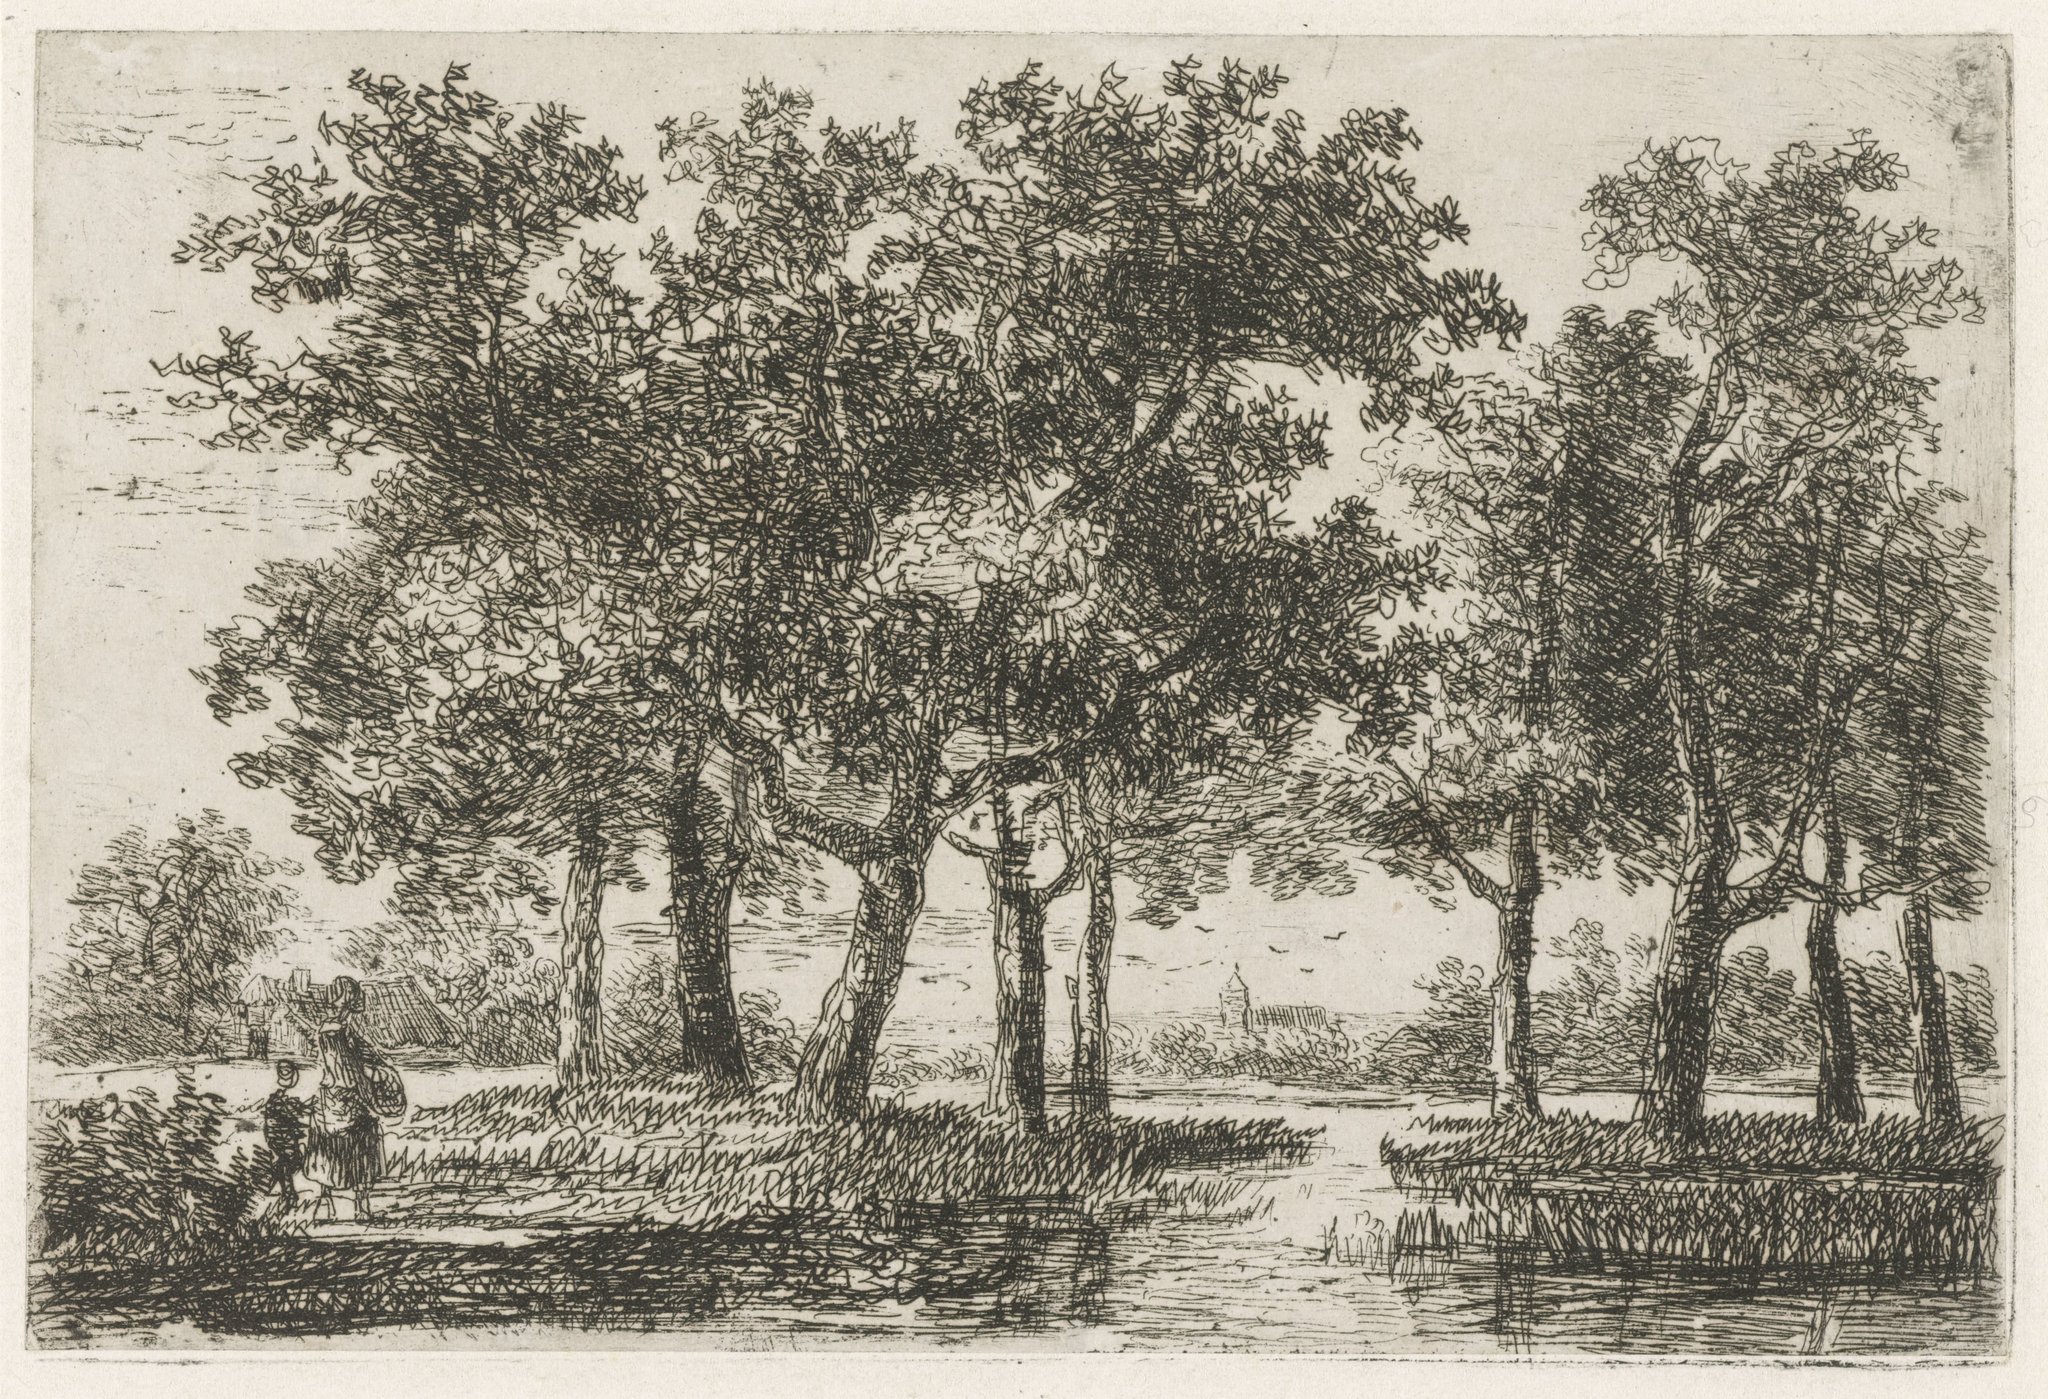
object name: print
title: Vrouw en kind met een tas met kruiden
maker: hermanus jan hendrik van rijkelijkhuysen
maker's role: painter, print maker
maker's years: 1813-1883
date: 1823-1883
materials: paper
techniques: drypoint, etching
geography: utrecht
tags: trees, church (exterior), lake, gathering herbs, farm or solitary house in landscape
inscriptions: collector's mark: Lugt 2228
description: Gezicht op een landschap met meertjes en bomen, met op de voorgrond een vrouw en een kind met een buidel. Op de achtergrond de contouren van een kerk en een boerenhoeve.